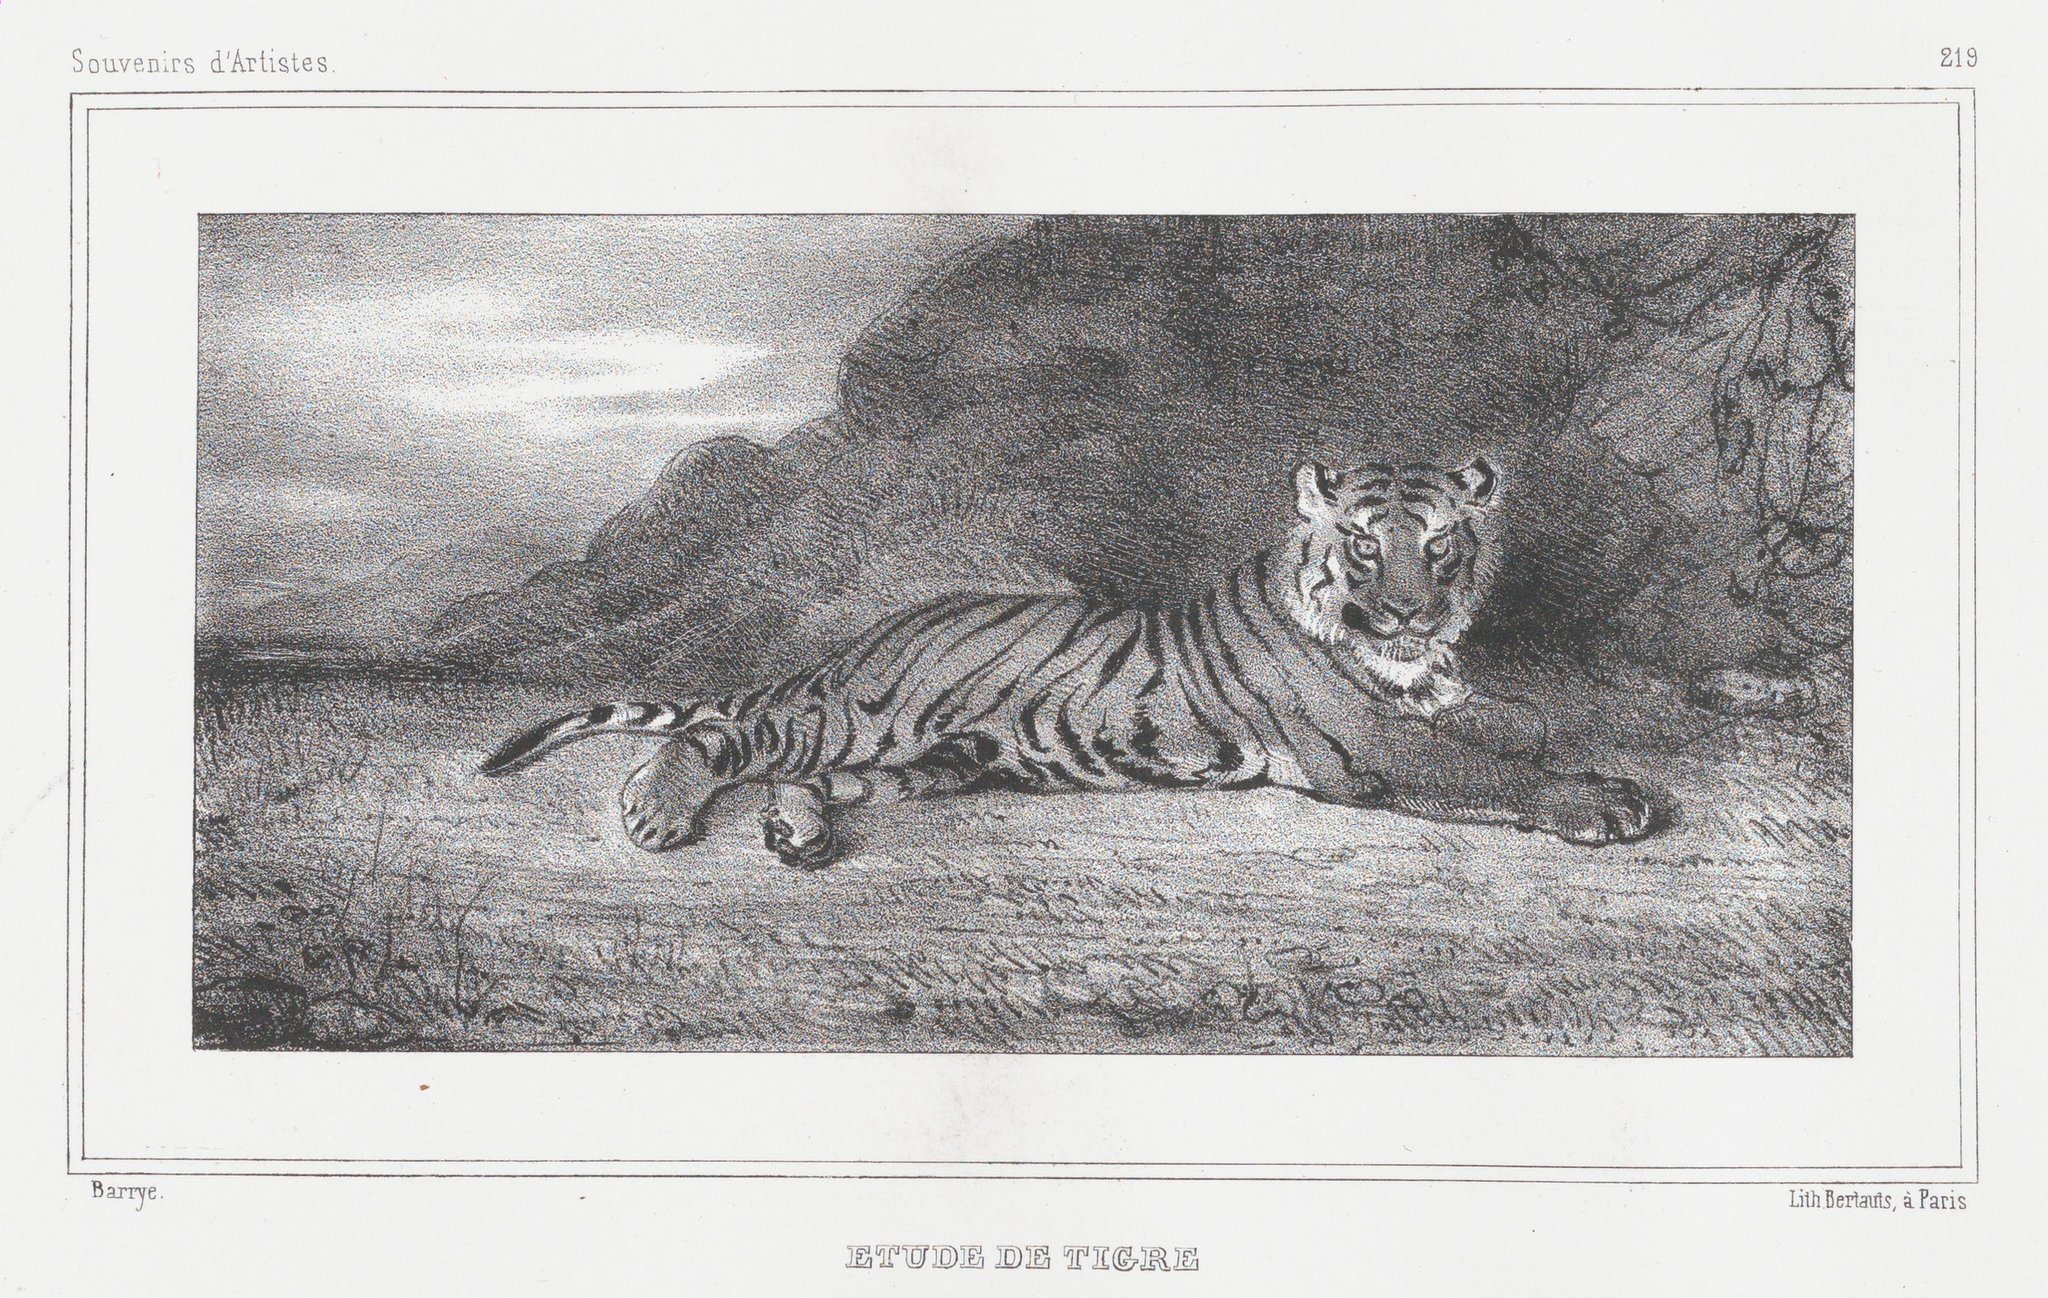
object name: print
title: Study of a Tiger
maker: antoine-louis barye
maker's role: artist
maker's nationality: french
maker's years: 1795-1875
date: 1832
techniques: lithograph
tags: tigers